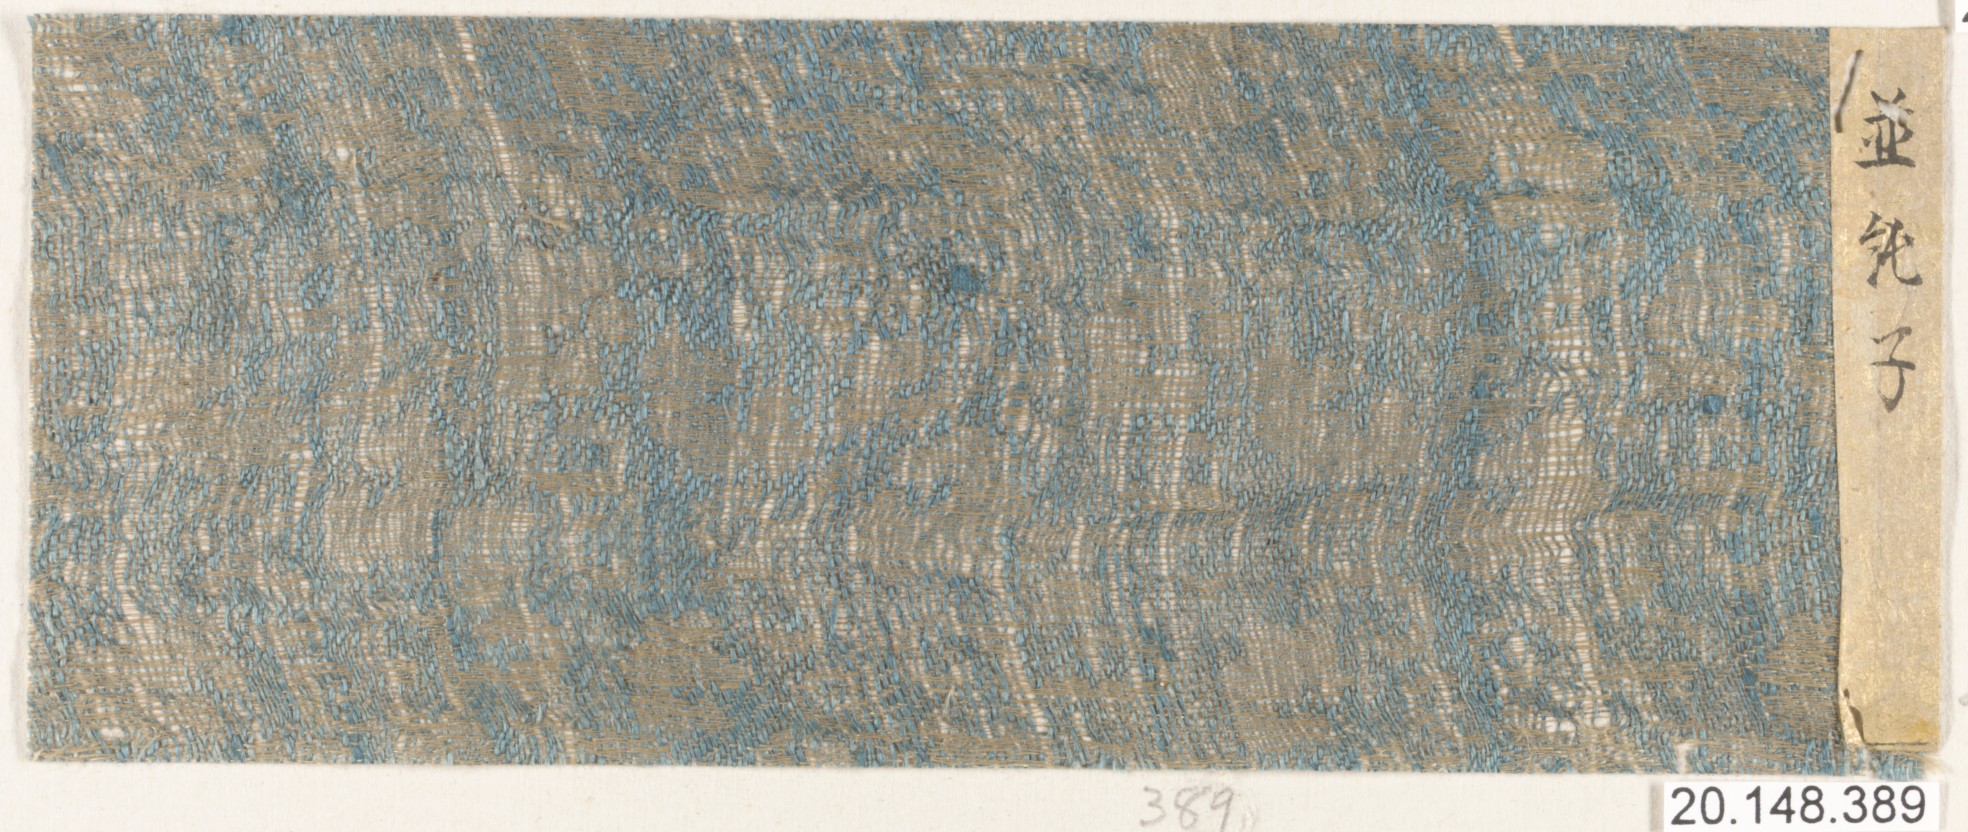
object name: piece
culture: chinese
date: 1501-1600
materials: silk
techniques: compound weave